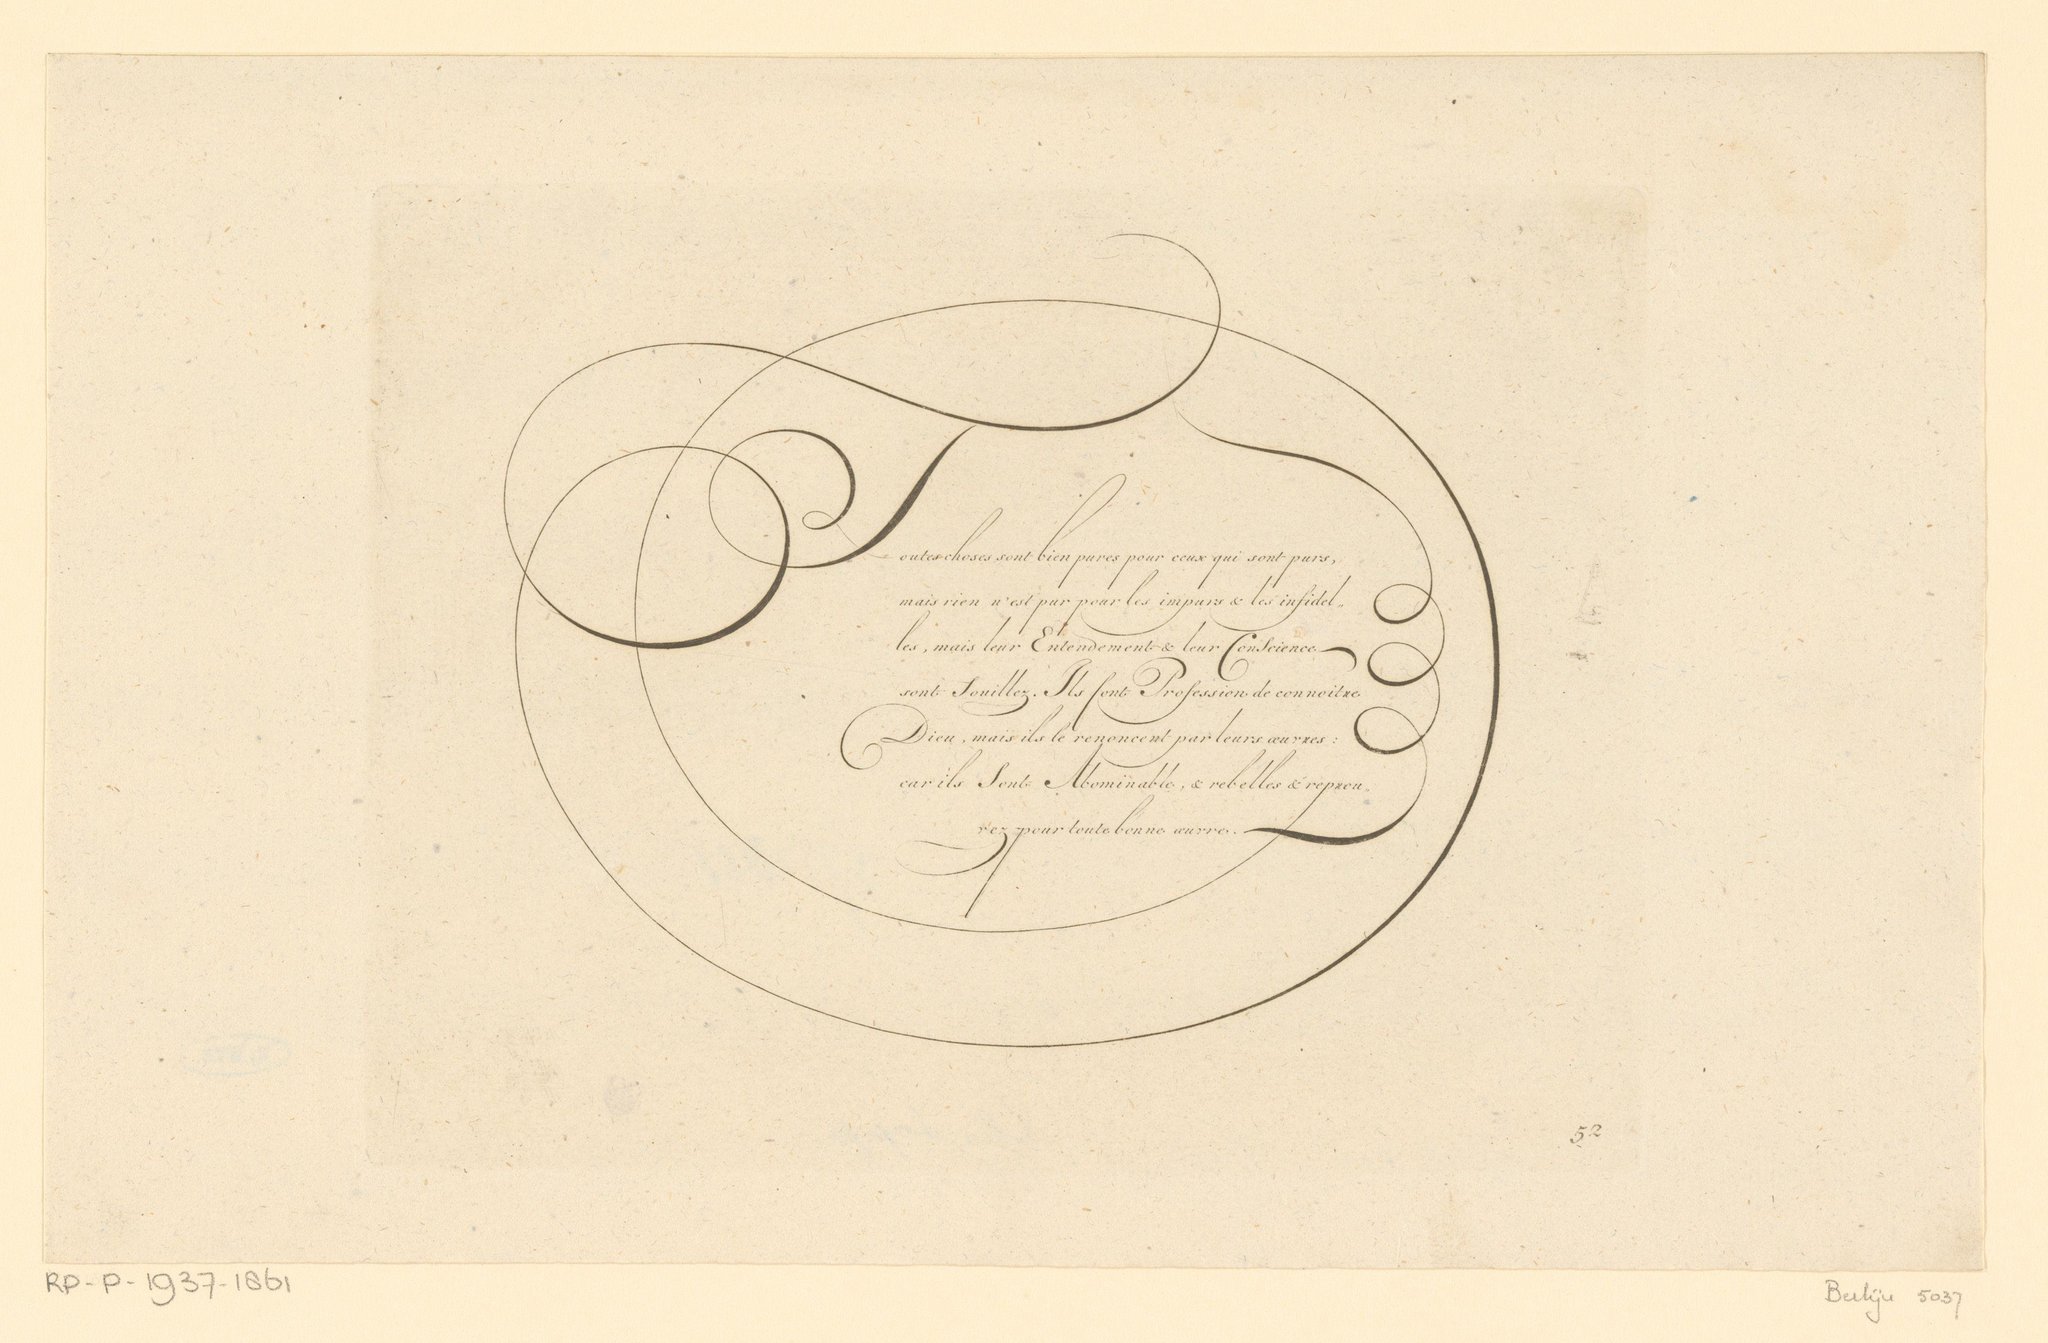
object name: print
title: Schrijfvoorbeeld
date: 1761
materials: paper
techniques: engraving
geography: amsterdam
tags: calligraphy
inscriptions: collector's mark: Lugt 2228, collector's mark: Lugt 2760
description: Gekalligrafeerde tekst: Toutes cheses sont bien pures pour ceux qui sont purs (...)